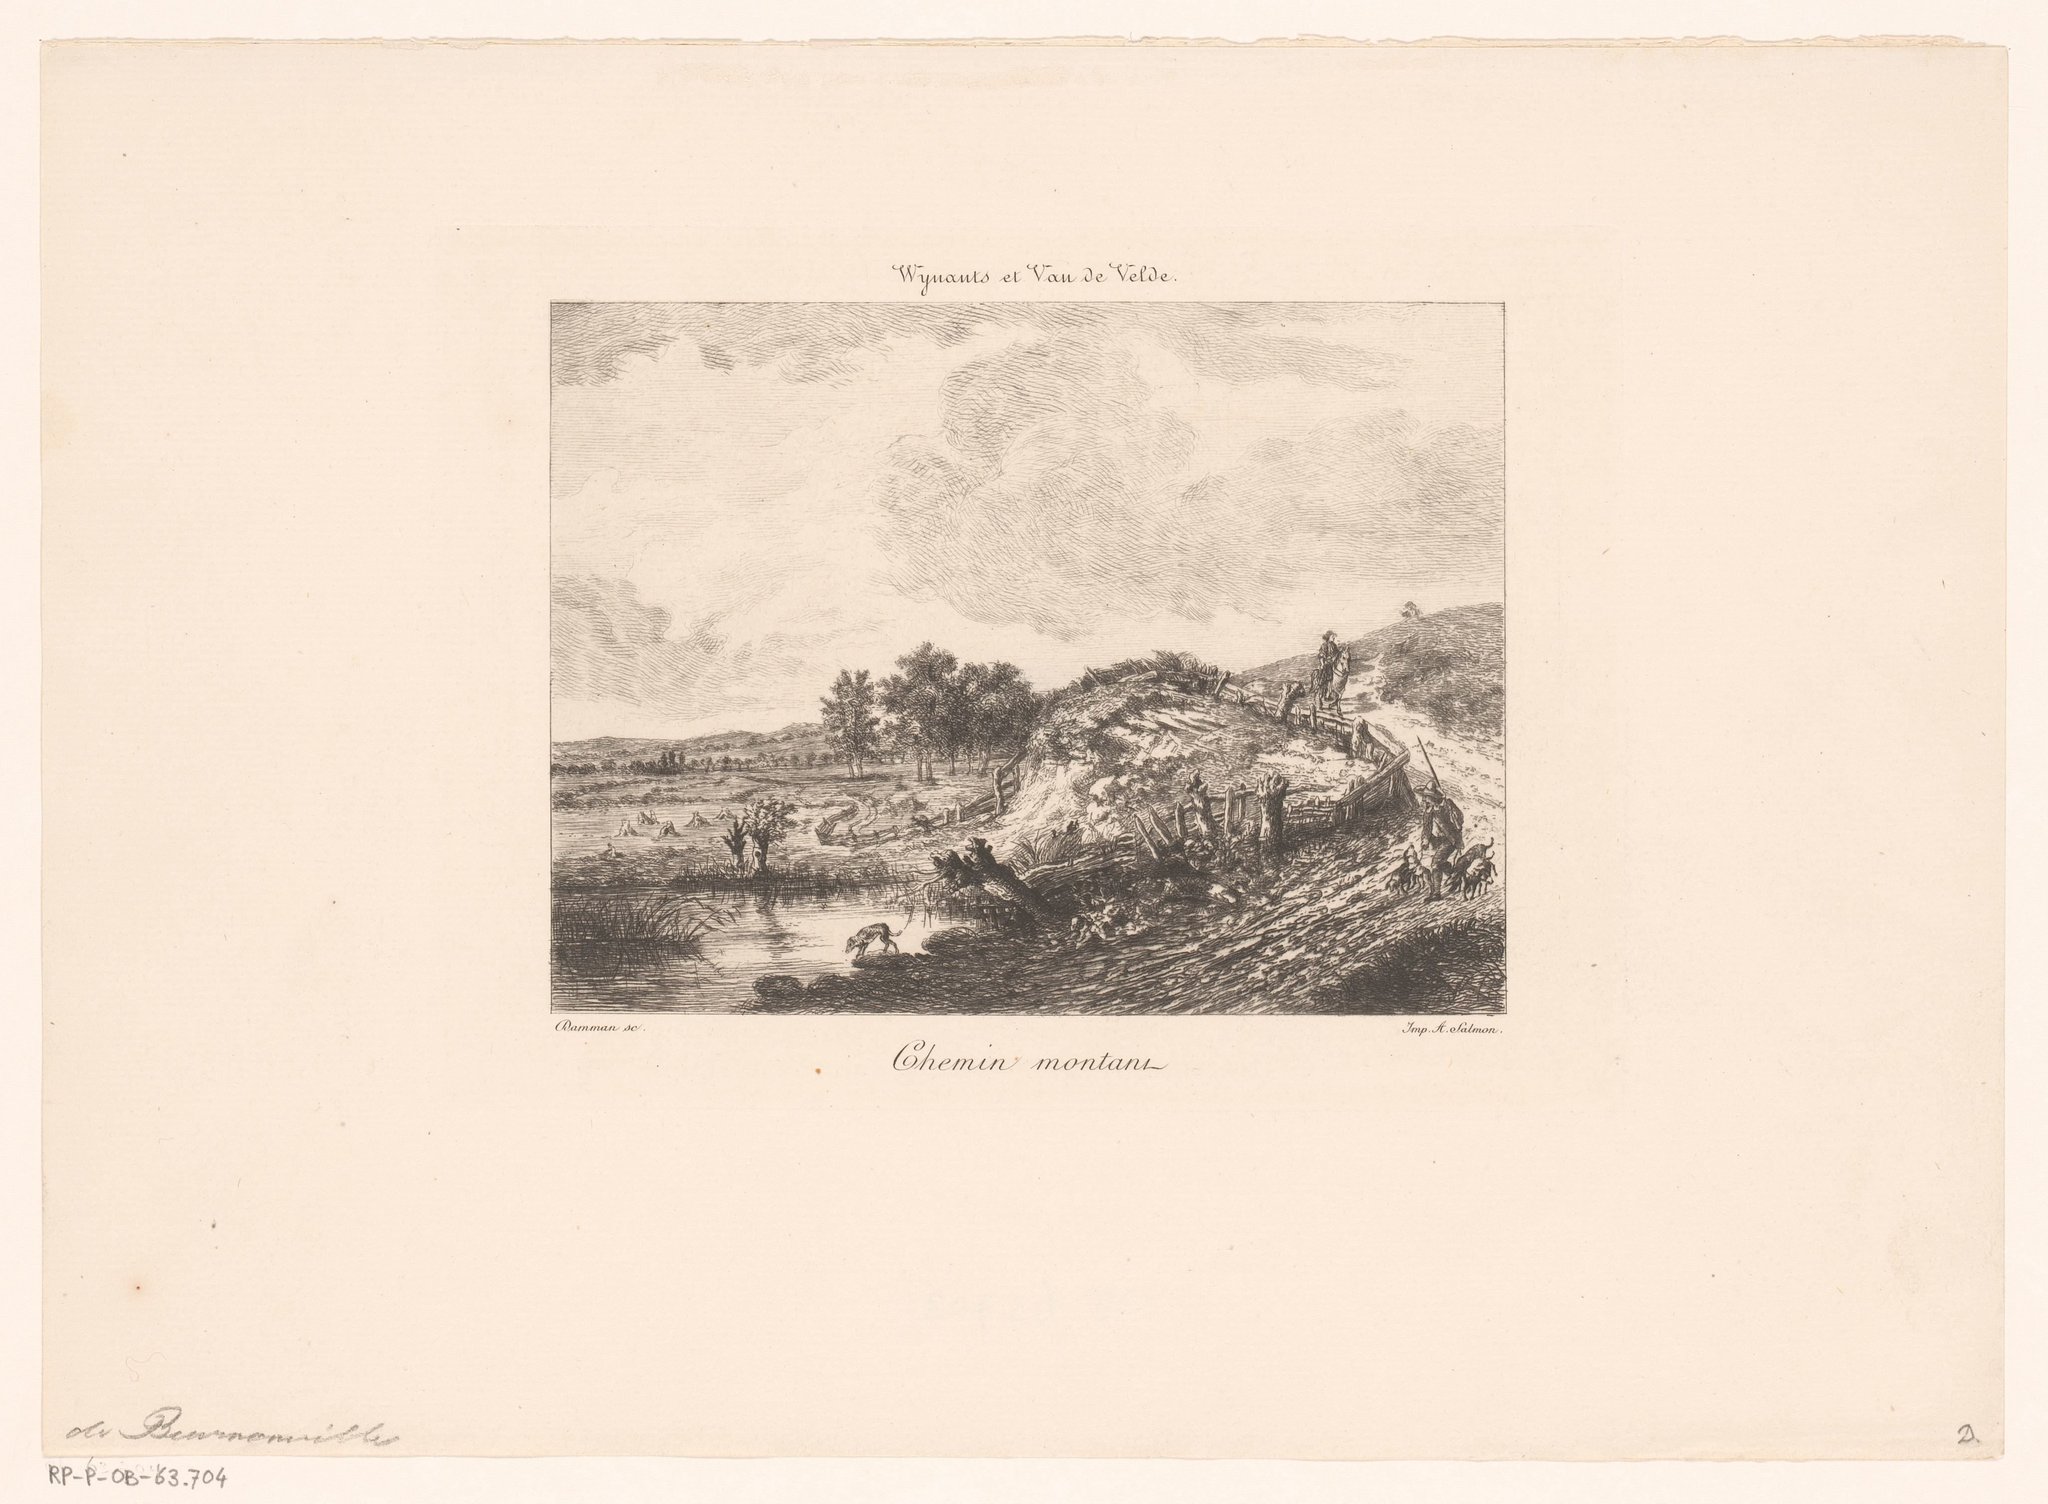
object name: print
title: Landschap met een ruiter en een jager met honden op een zandpad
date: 1881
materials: paper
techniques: etching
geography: paris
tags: landscapes, hunting dogs, hunter, road, path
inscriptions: collector's mark: Lugt 2228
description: Prent afkomstig uit een veilingcatalogus: "Catalogue des Tableaux anciens composant la très importante collection de Monsieur le Baron de Beurnonville", uitgegeven in 1881 te Parijs door Pillet en Dumoulin. De veiling vond plaats op 9 tot en met 14 en 16 mei 1881.